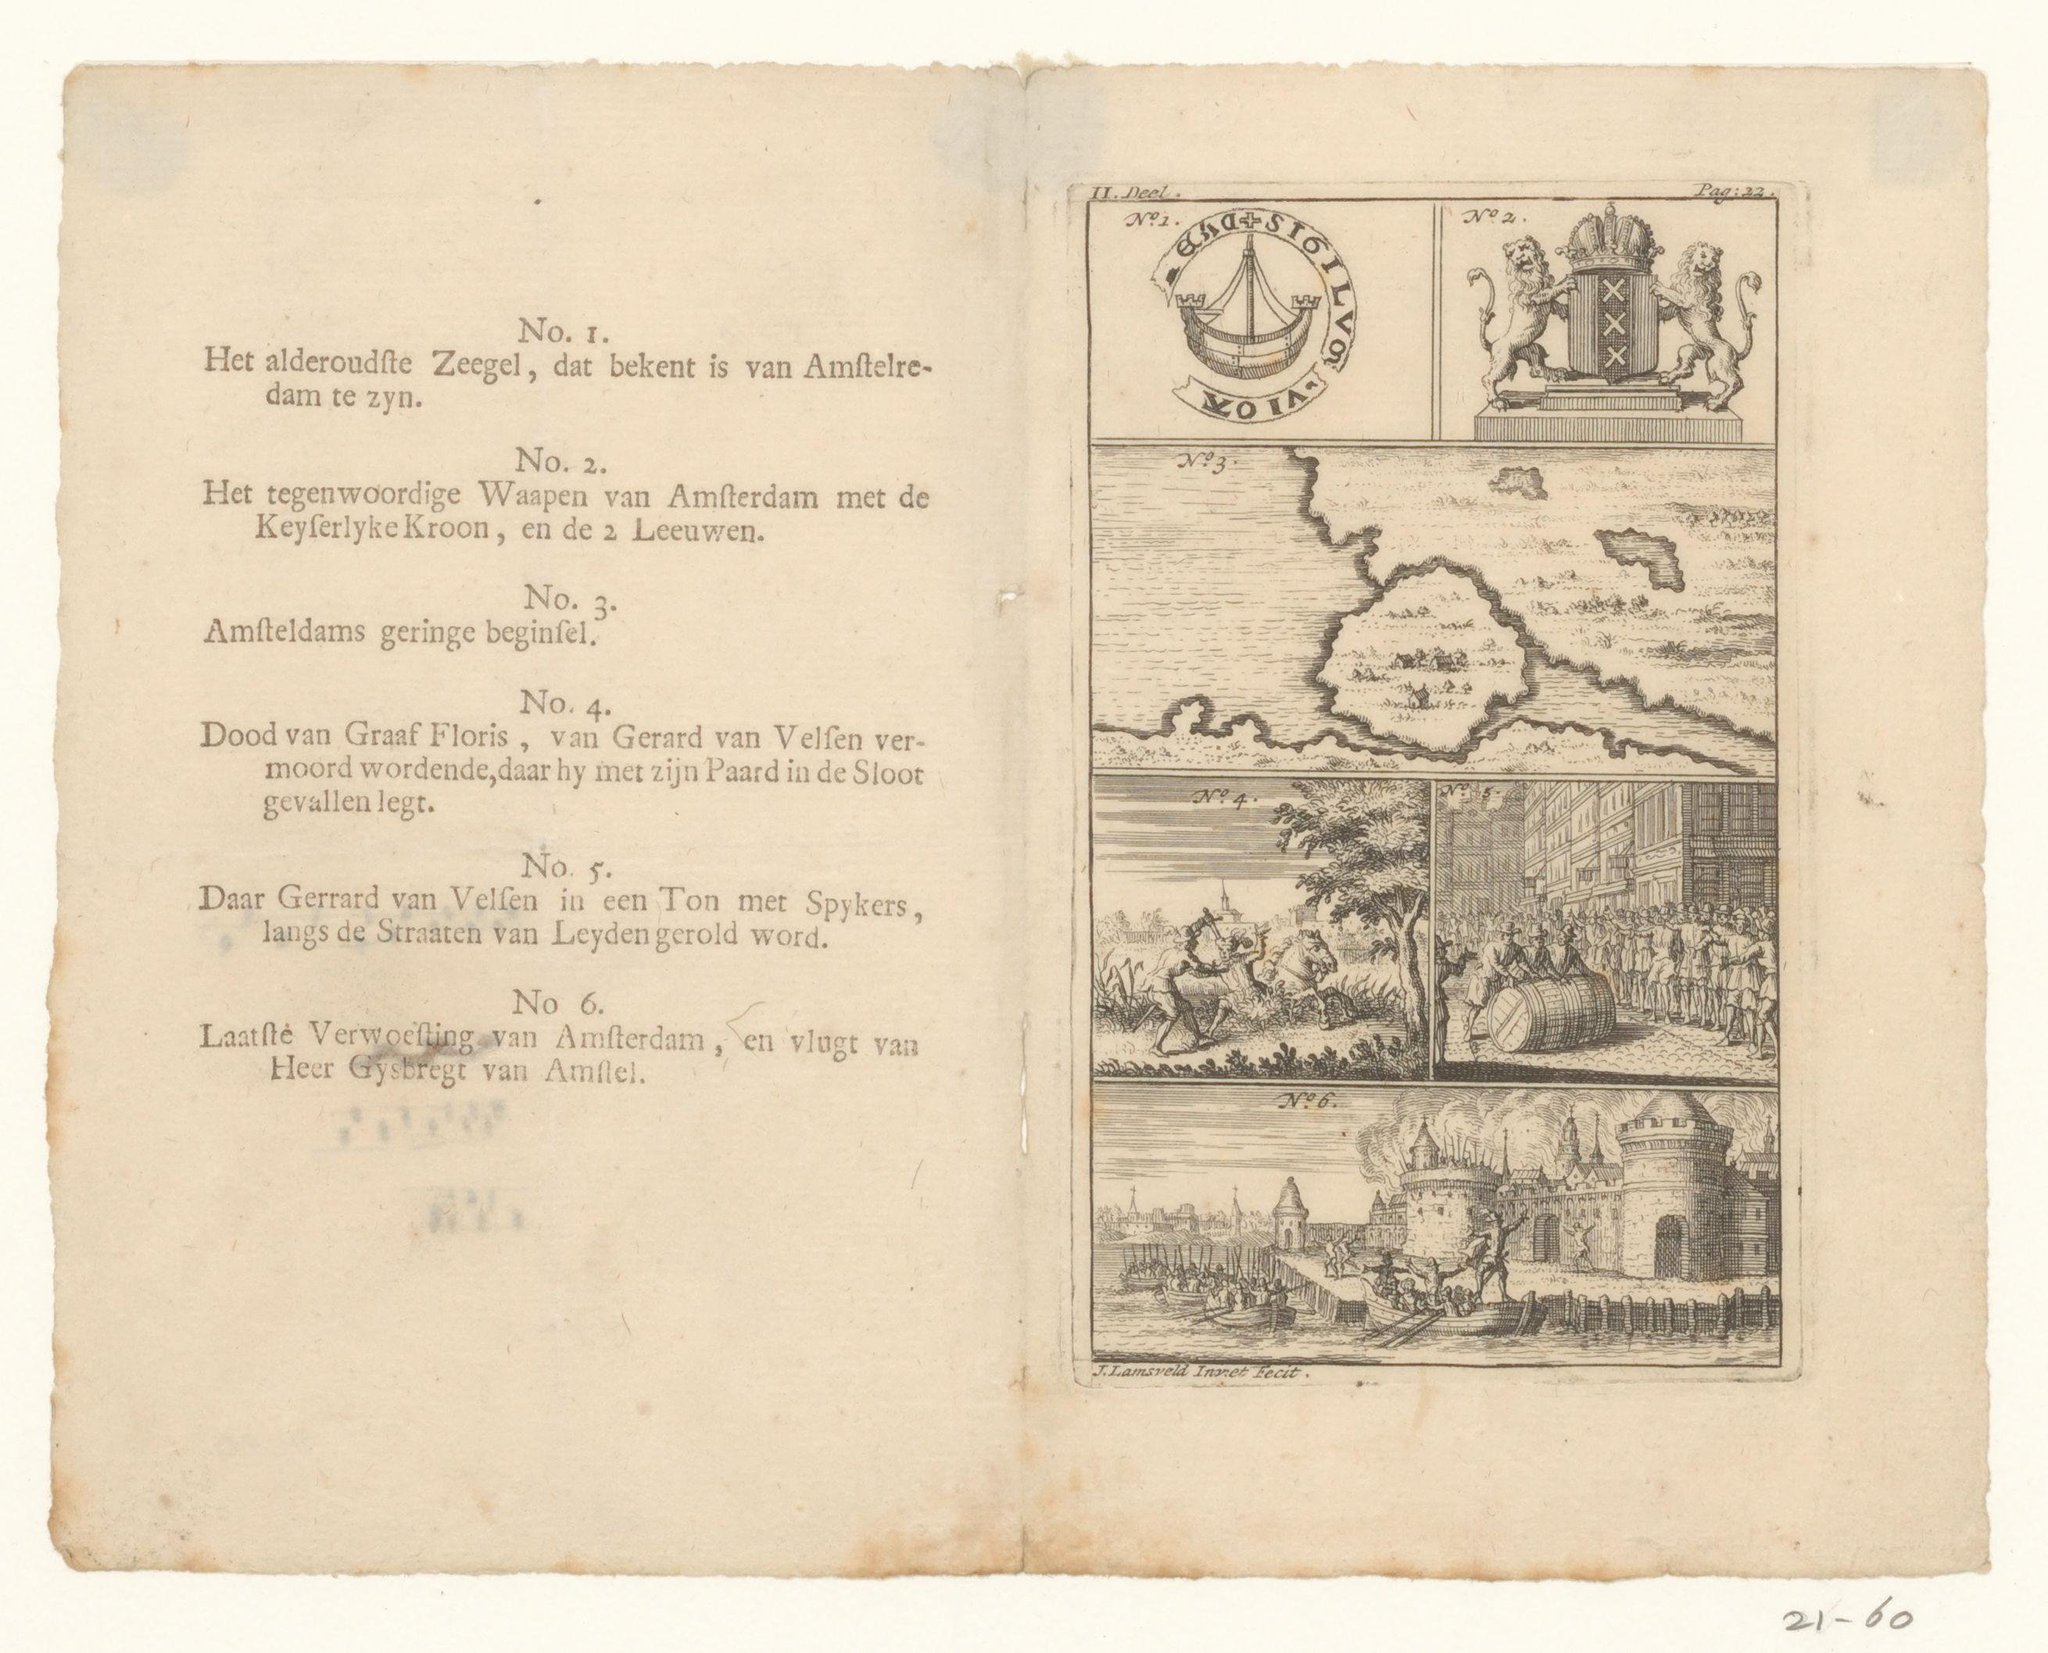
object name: book illustration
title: Zes verschillende voorstellingen betrekking hebbende op Amsterdam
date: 1723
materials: paper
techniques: etching, letterpress printing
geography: northern netherlands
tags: leiden, floris v (graaf van holland en zeeland), coat of arms (as symbol of the state, etc.) (+ city; municipal), historical persons, setting on fire (of conquered city), maps of cities, seal (symbol of sovereignty), historical events and situations, amsterdam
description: De voorstellingen, genummerd van een tot en met zes, zijn op het bijbehorende tekstblad links voorzien van toelichting. Prent links- en rechtsboven gemerkt: II. Deel. - Pag: 22. Onderwerpsrubriek binnen de Atlas Amsterdam: wapens en zegels.